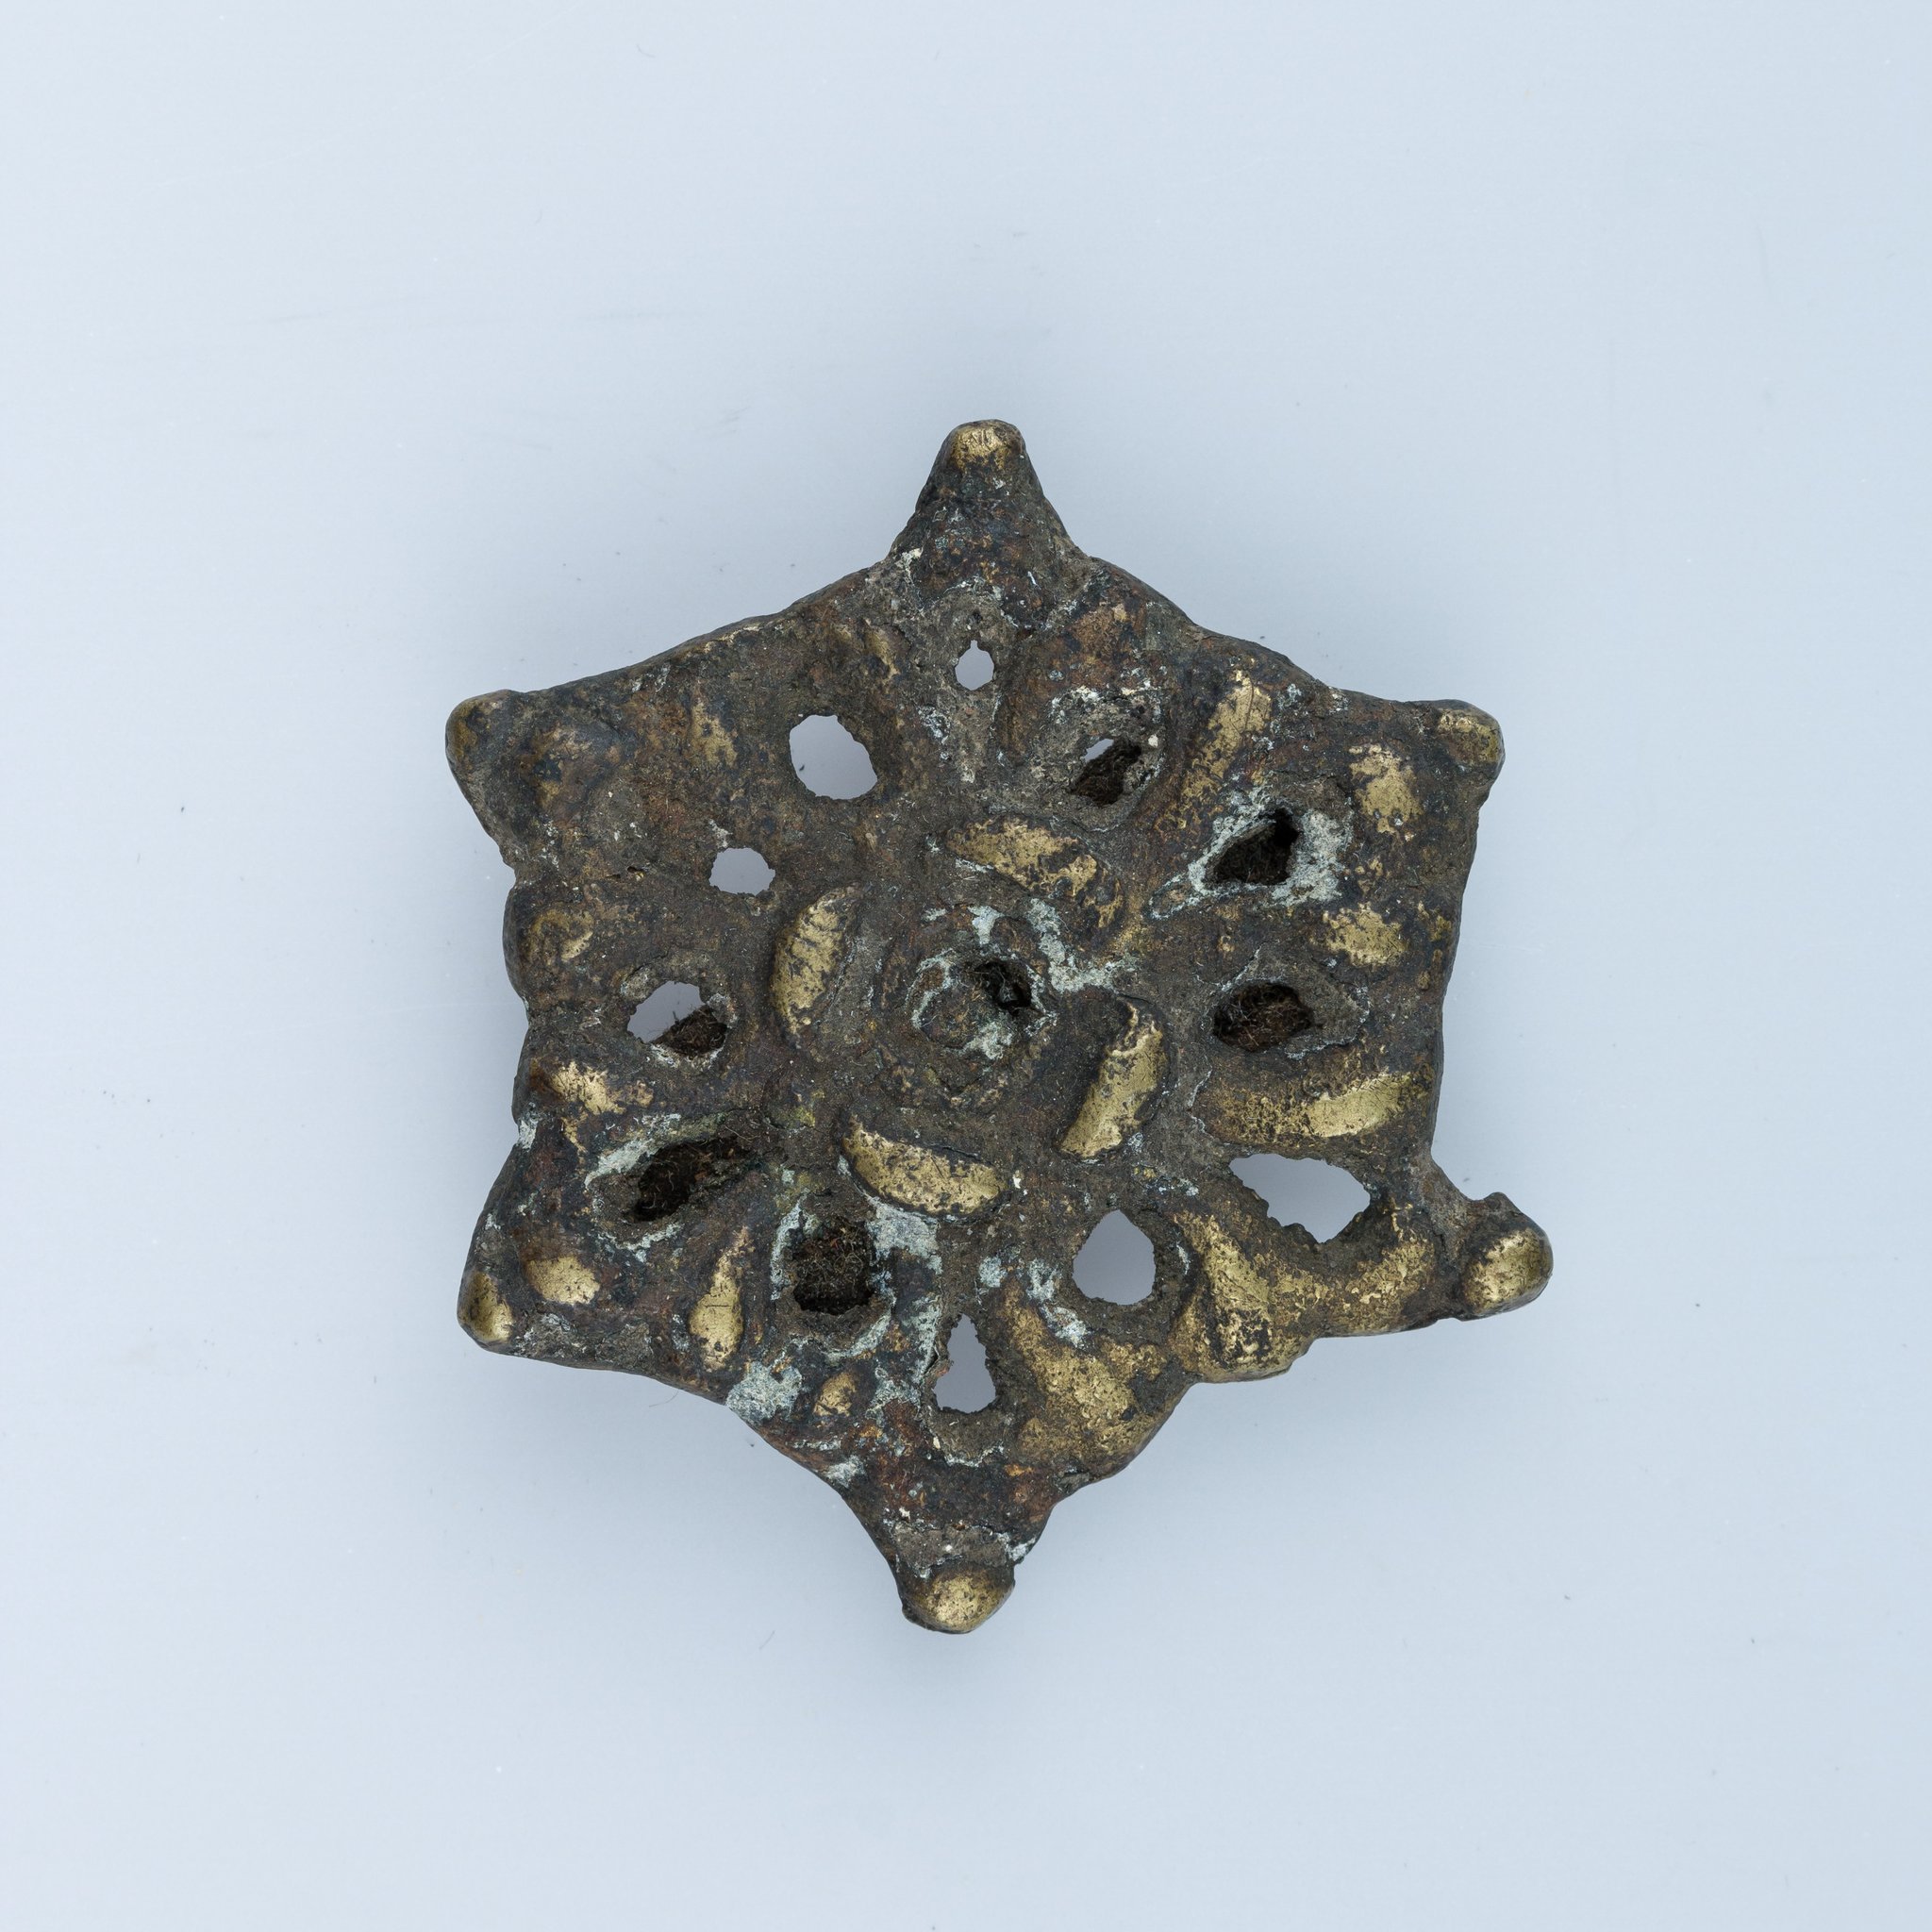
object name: ornament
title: Rosace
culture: european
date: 1501-1533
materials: brass